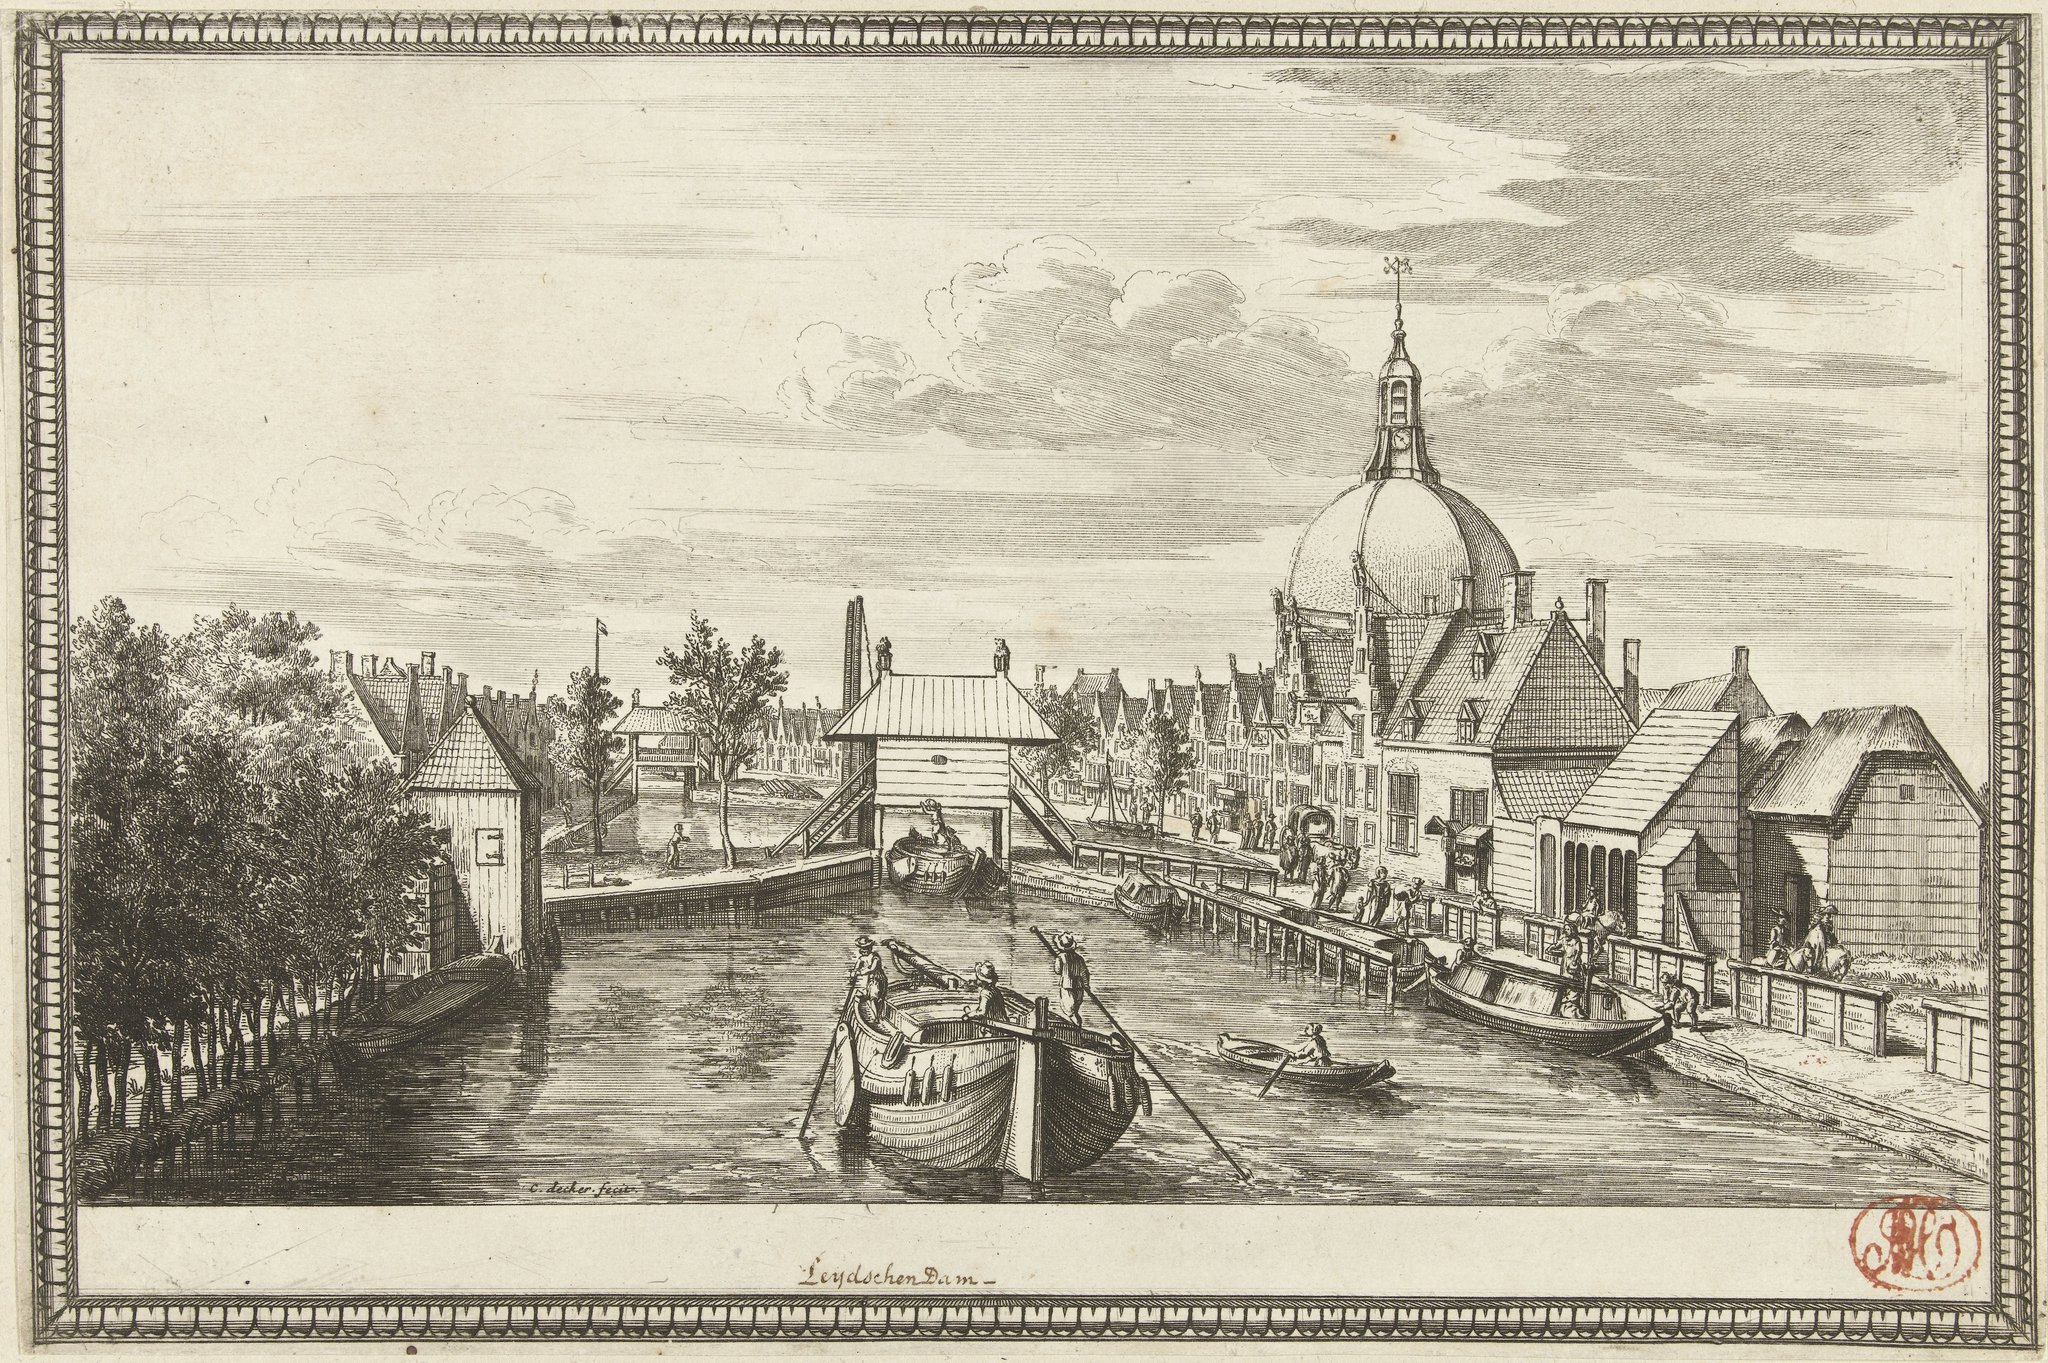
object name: print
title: Gezicht op Leidschendam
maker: coenraet decker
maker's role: print maker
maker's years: 1650-1685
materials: ink, paper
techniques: etching, pen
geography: amsterdam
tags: prospect of village, silhouette of village, dam (in canal)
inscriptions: collector's mark: Lugt 2228, inscription: ‘Leydschendam’, collector's mark: Lugt 195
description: Tweede staat van deze prent is in 1678 voor het eerst uitgegeven als onderdeel van de rand van de zogenaamde Kaart Figuratief (Caerte figuratyff / Kaerte figuratyf) van Delft, een wandkaart van Delft. Deze kaart bestaat uit een plattegrond van Delft (RP-P-AO-11-8A) met daaromheen een rand. De rand bestaat uit een profiel van Delft (RP-P-AO-11-11), een profiel van Delfshaven met daaronder de wapenschilden van de burgemeesters van de stad (RP-P-AO-13-51-1 en RP-P-AO-13-51-2), 24 kleinere prenten (kaarten, afbeeldingen van gebouwen en graven van bekende personen, o.a. huidige prent, RP-P-AO-11-15, RP-P-AO-11-16, RP-P-AO-11-17, RP-P-AO-11-18, RP-P-AO-11-19, RP-P-AO-11-20, RP-P-AO-11-21, RP-P-AO-11-23, RP-P-AO-11-24, RP-P-AO-11-27, RP-P-AO-11-28, RP-P-AO-11-29, RP-P-AO-11-30, RP-P-AO-11-31, RP-P-AO-11-33C, RP-P-AO-11-35, RP-P-AO-11-35-2, RP-P-AO-13-49, RP-P-AO-13-52, RP-P-AO-13-53, RP-P-AO-13-54-1 en RP-P-1909-6463) en een beschrijving van de stad (RP-P-AO-11-8E). De eerste druk van deze Kaart Figuratief (1678) werd, in opdracht van het Delftse stadsbestuur, verzorgd door Pieter Smith. In 1680 leverde Smith ook vijfhonderd afdrukken van de randprenten die bestemd waren voor Dirk Evertsz. Bleyswijcks 'Beschryvinge der stadt Delft' (1667) en het tweede deel: 'Vervolg van de beschryvinge der stadt Delft' (1680). In het tweede deel zat een bijlage waarin beschreven staat welke prenten waar in het eerste en tweede deel ingebonden dienden te worden. Een deel van de prenten was dus bestemd voor het in 1667 verschenen eerste deel en kon met het verschijnen van het tweede deel in 1680 alsnog worden ingebonden. Hierdoor wordt vaak gedacht dat de prenten uit het eerste deel dateren uit 1667, hetgeen niet klopt. De tweede staat van de huidige prent is zodoende ook gebruikt in: Bleyswijck, Dirk Evertsz. Beschryvinge der stadt Delft, betreffende des selfs situatie, oorsprong en ouderdom, opkomst en voortgangh (…). Delft: Arnold Bon, 1667 (prenten vanaf 1680 ingebonden), p. 102. Pieter Mortier (I) verzorgde in 1703, tevens in opdracht van het stadsbestuur, een tweede uitgave van de Kaart Figuratief. Voor deze druk bracht graveur Thomas van der Wilt enkele aanpassingen aan op de platen van de plattegrond. De randplaten lijken, op de plaat met de wapens van de burgemeesters na, ongewijzigd te zijn gebleven. De plattegrond is in 1752, waarschijnlijk zonder de randprenten, opnieuw uitgegeven.